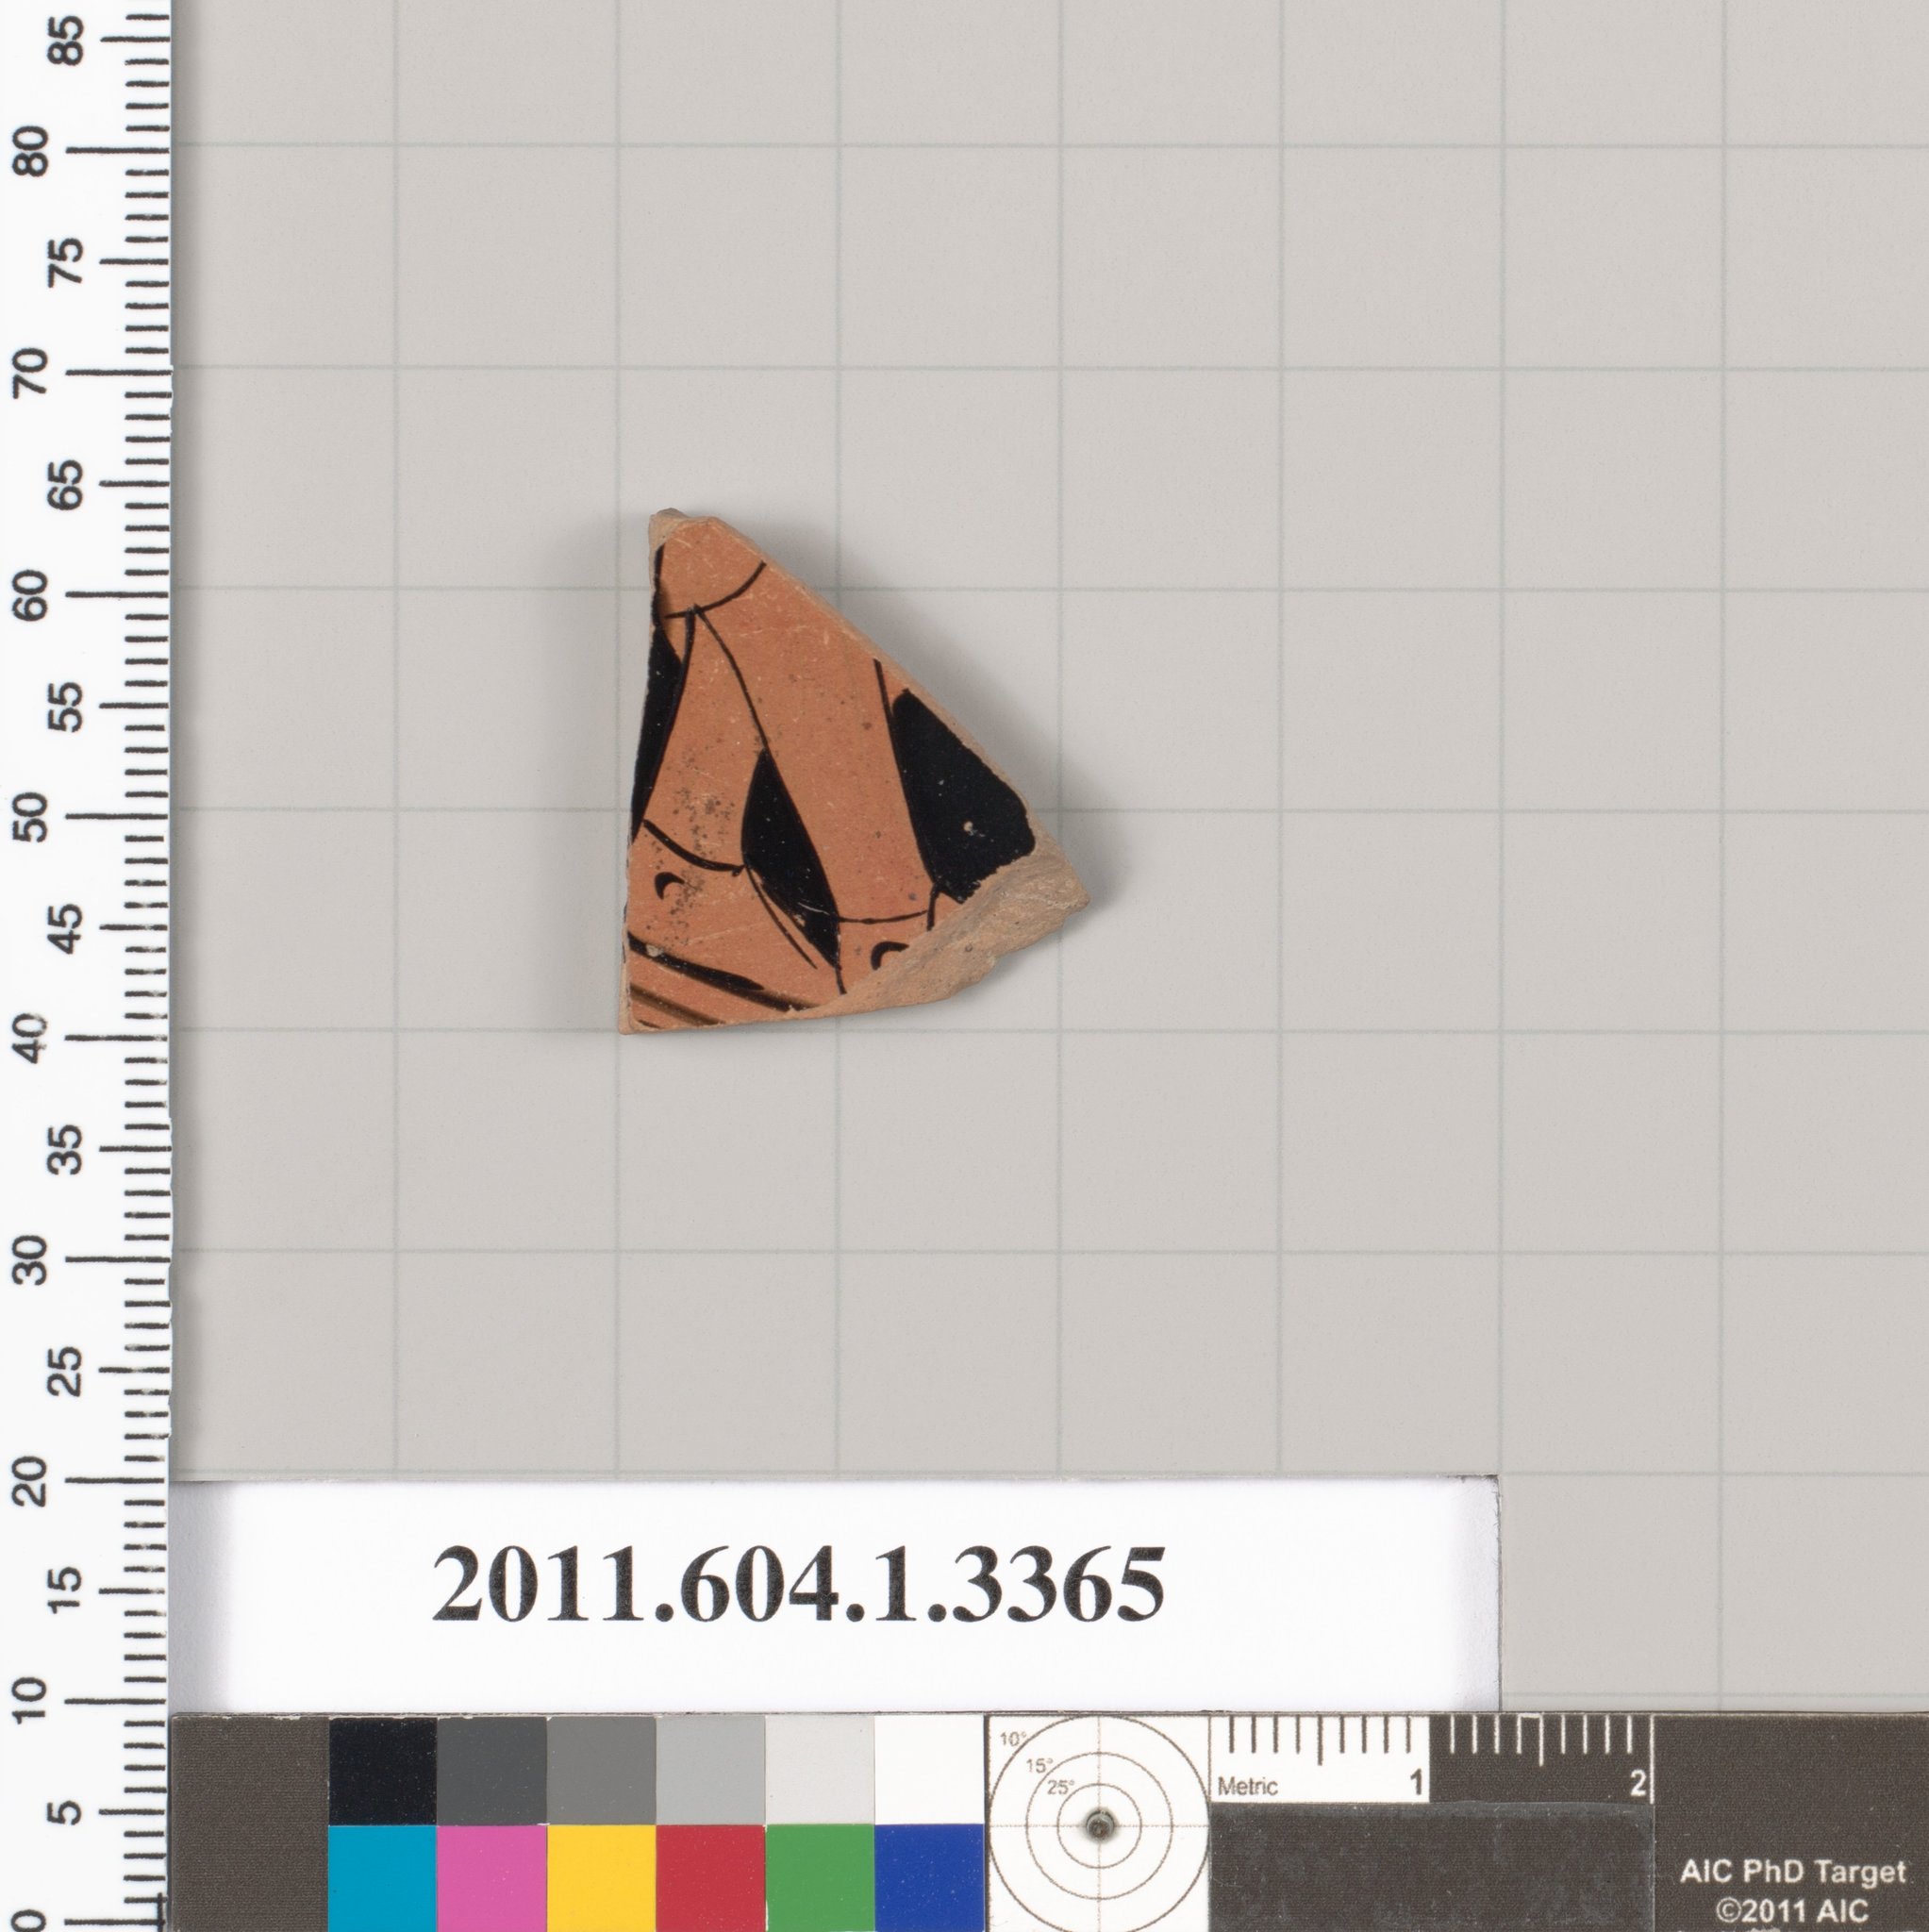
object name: kylix fragment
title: Terracotta fragment of a kylix (drinking cup)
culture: greek, attic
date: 475-451 BCE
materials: terracotta